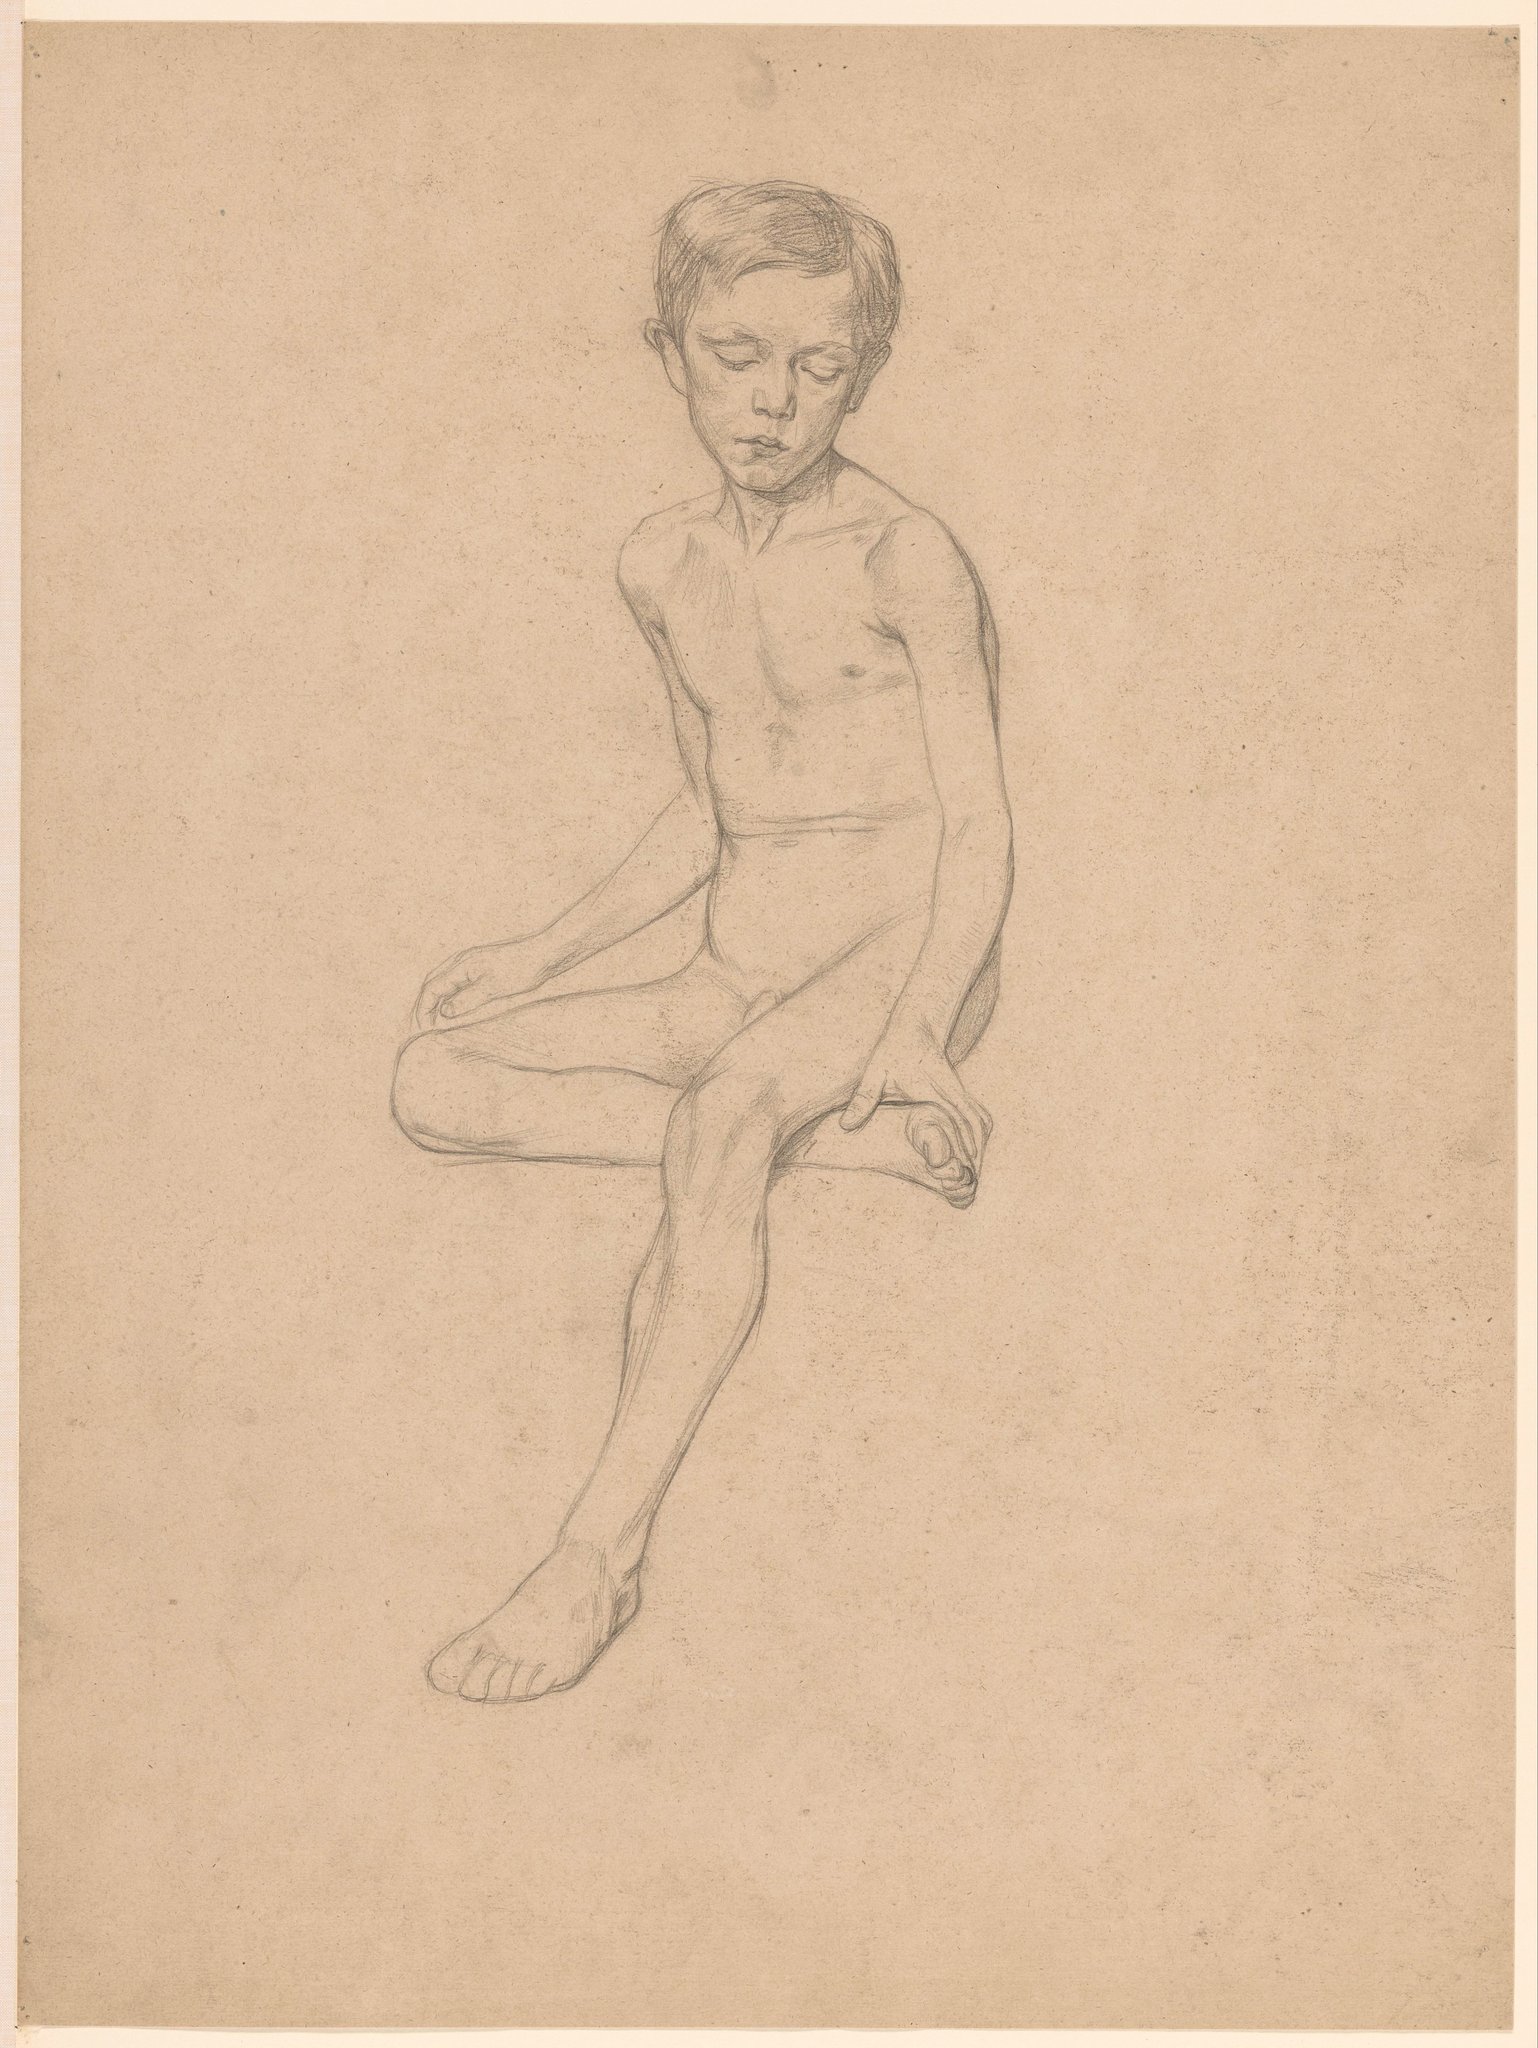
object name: drawing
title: Zittende naakte jongen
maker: jan veth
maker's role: designer, draughtsman, painter, print maker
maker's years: 1864-1925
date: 1874-1925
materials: chalk, paper